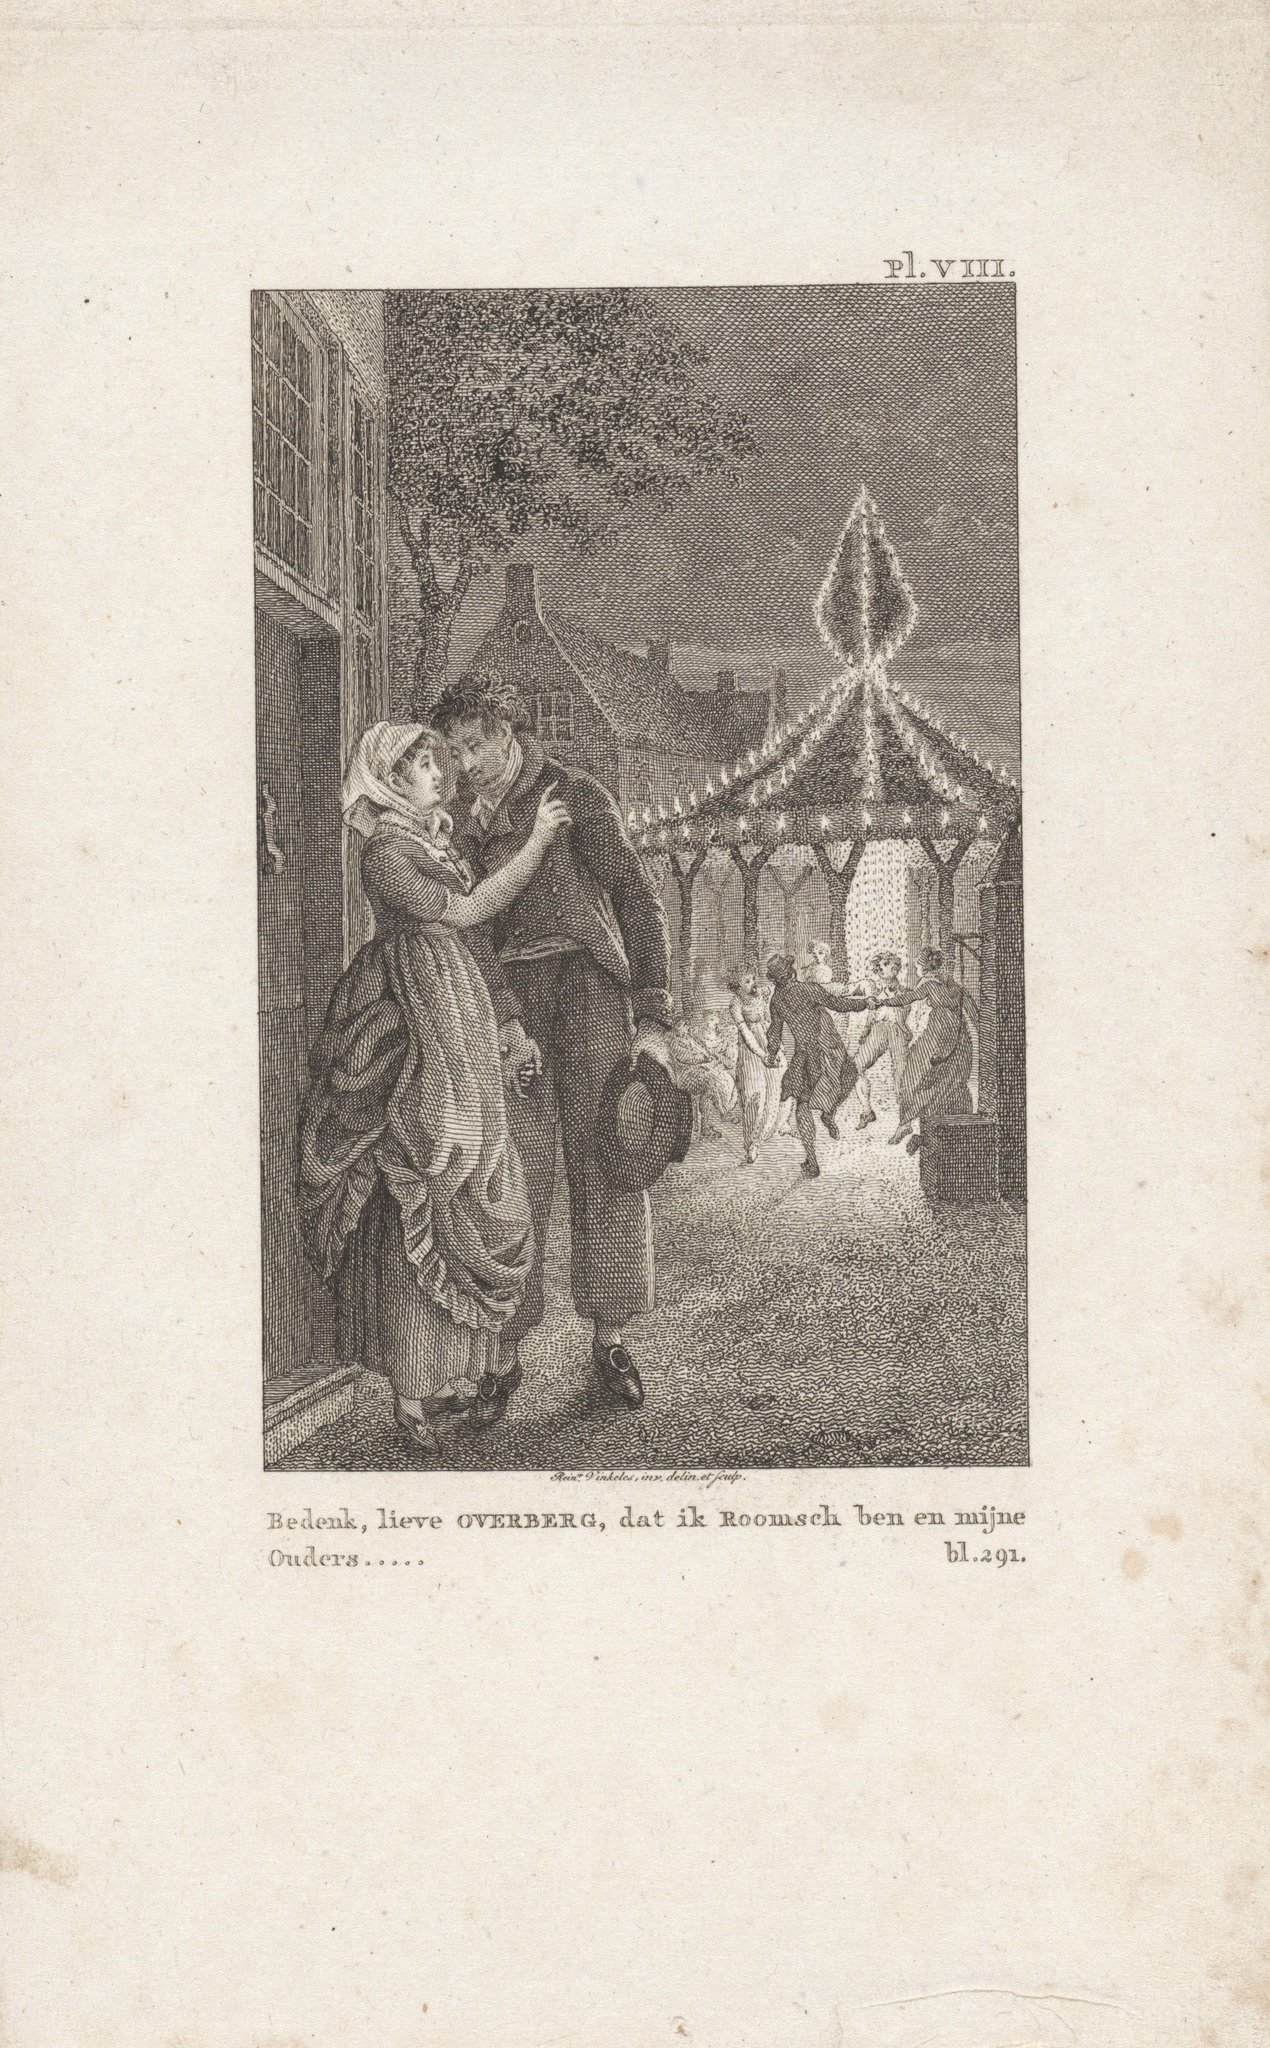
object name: print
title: Agneta en Frederik houden elkaars hand vast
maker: reinier vinkeles (i)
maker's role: draughtsman, print maker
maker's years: 1741-1816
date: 1804-1805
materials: paper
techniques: engraving, etching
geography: amsterdam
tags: public festivities, lighting; lamps, group dancing, lovers' meeting, index finger forwards, pointing, indicating, night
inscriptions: collector's mark: Lugt 2228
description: Nachtgezicht met Agneta en Frederik die een gesprek voeren terwijl ze elkaars hand vast houden. Op de achtergrond is een feest gaande. Illustratie bij het verhaal Frederik en Agneta.